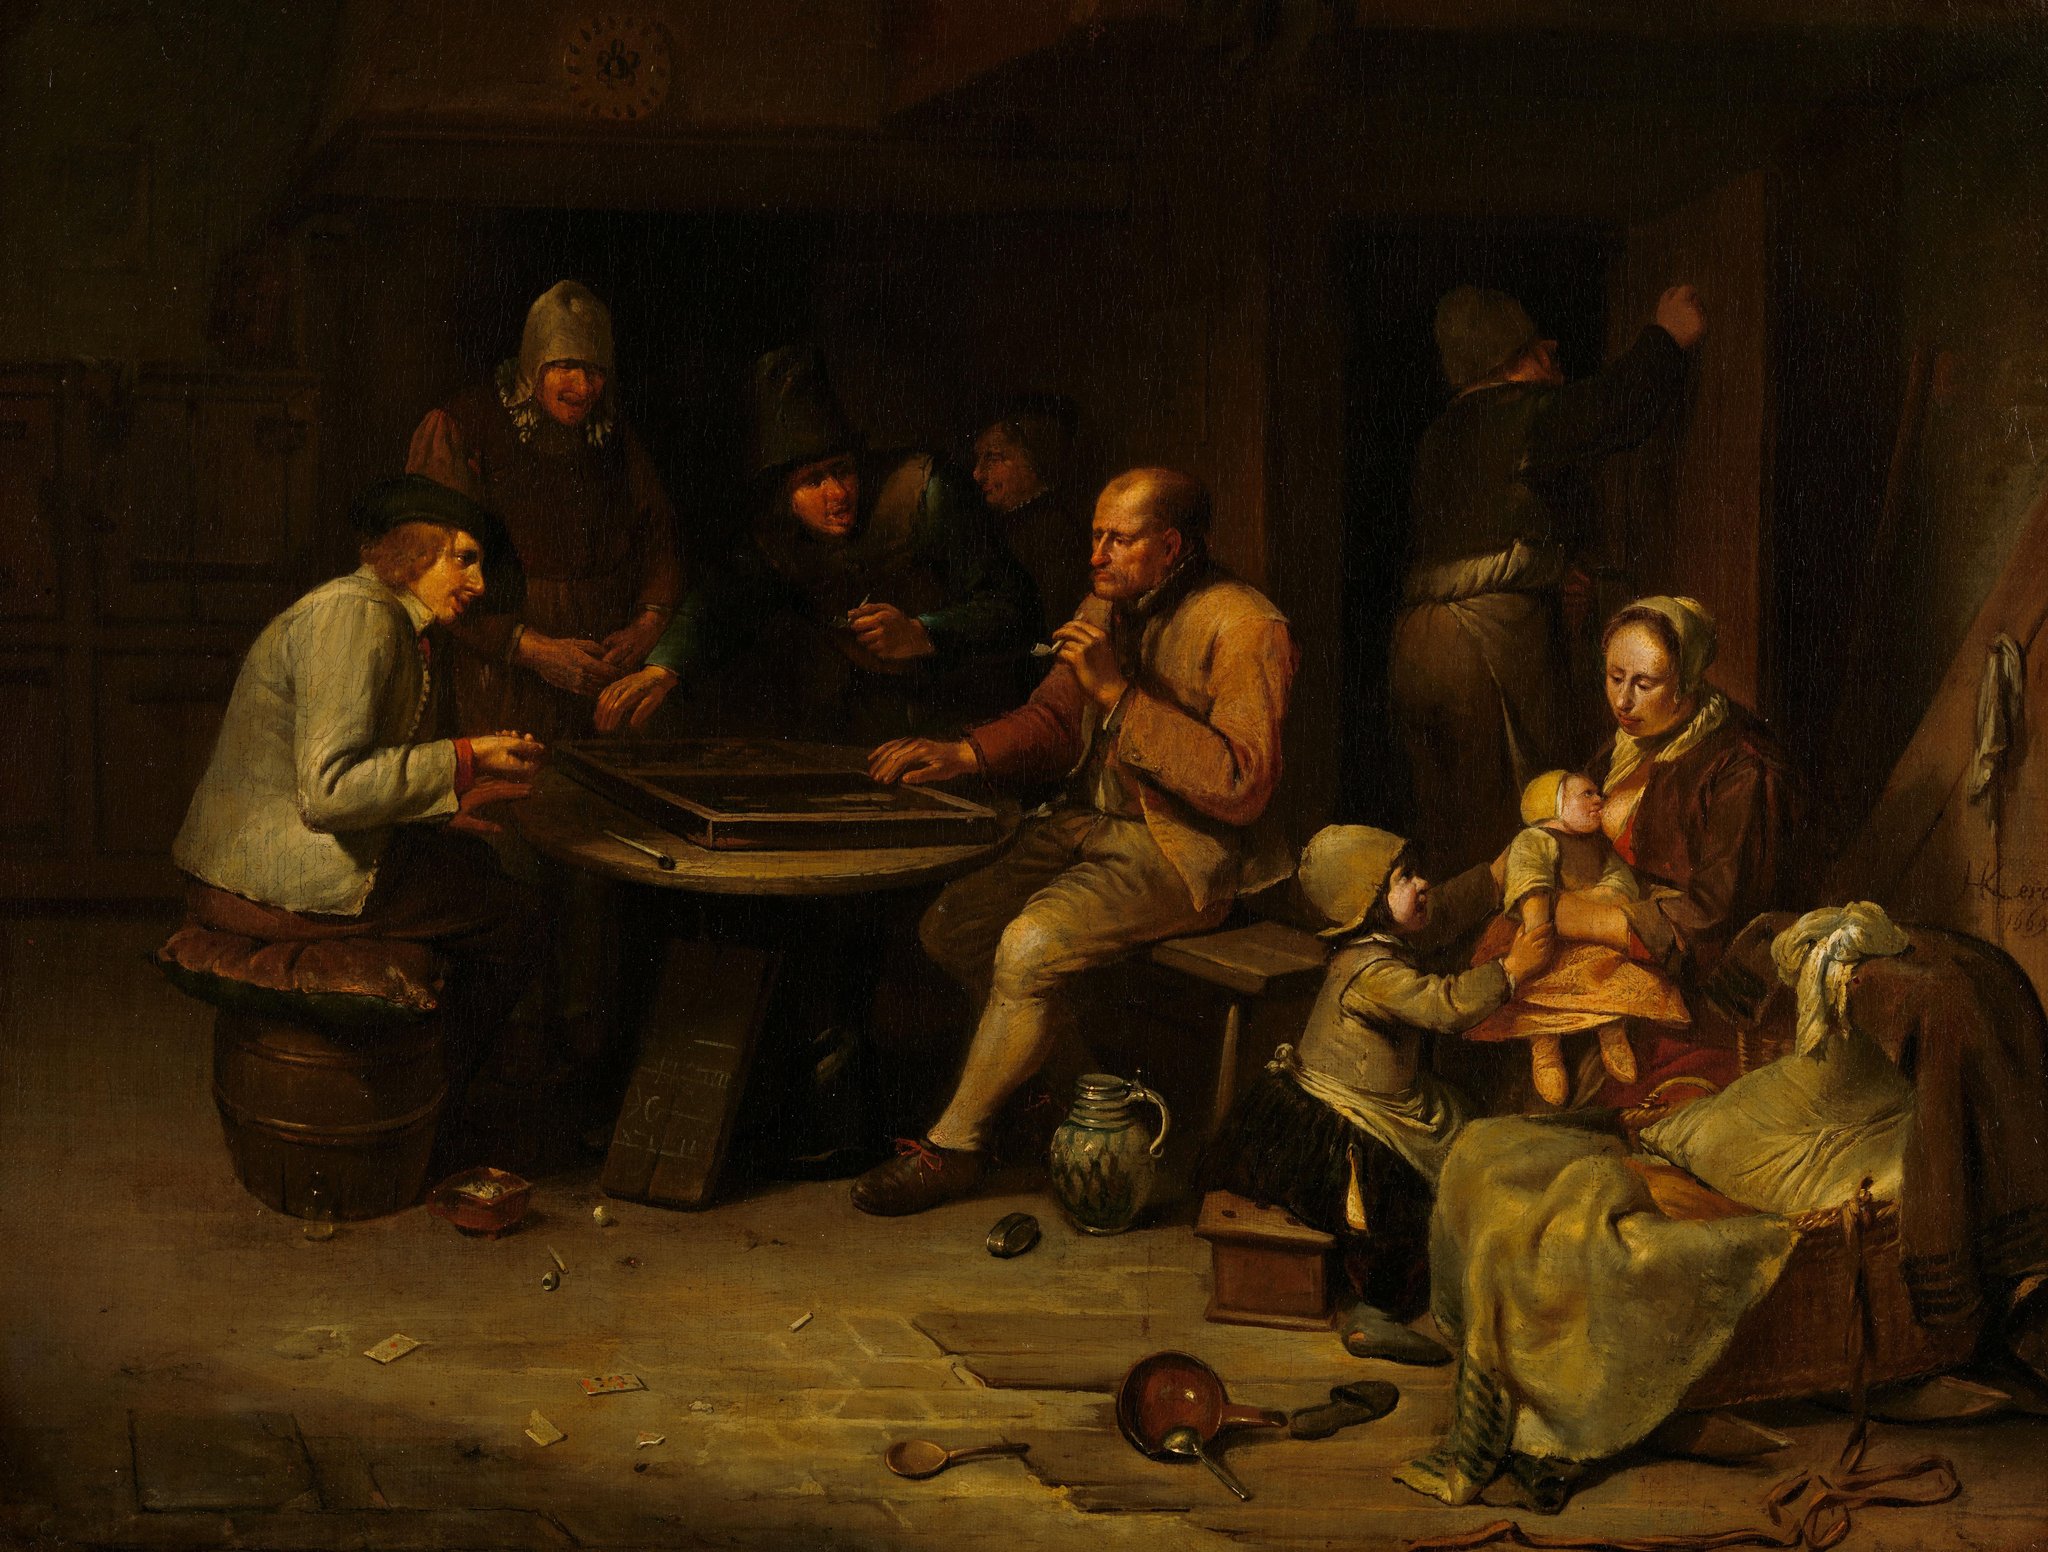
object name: painting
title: Ann Inn with Backgammon Players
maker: egbert van heemskerck (i)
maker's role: draughtsman, painter, print maker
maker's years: 1634-1704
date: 1669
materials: canvas, oil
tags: nursing, suckling, inn, coffee-house, public house, etc., backgammon, tric-trac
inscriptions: signature and date: ‘HKerck 1669’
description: Interieur van een herberg met triktrakspelers. Op de voorgrond een wieg en een moeder die haar kind de borst geeft.